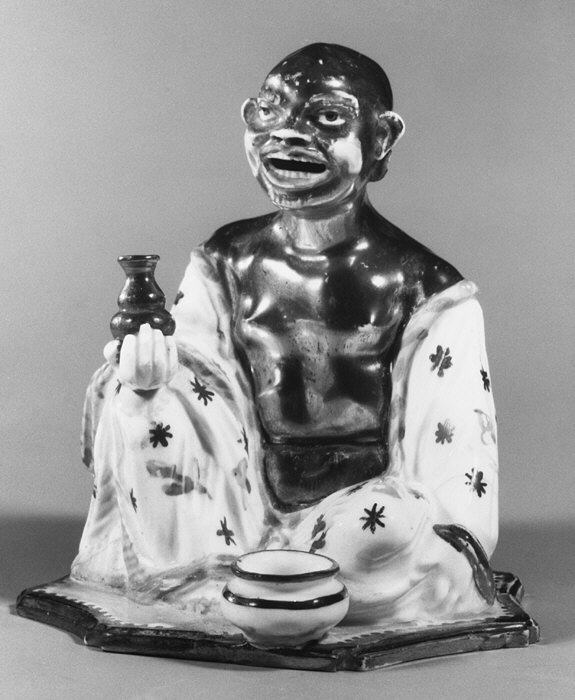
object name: figure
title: Buddhist Divinity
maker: meissen manufactory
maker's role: manufactory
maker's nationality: german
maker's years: 1710-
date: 1720-1725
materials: hard paste porcelain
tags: men,buddhism